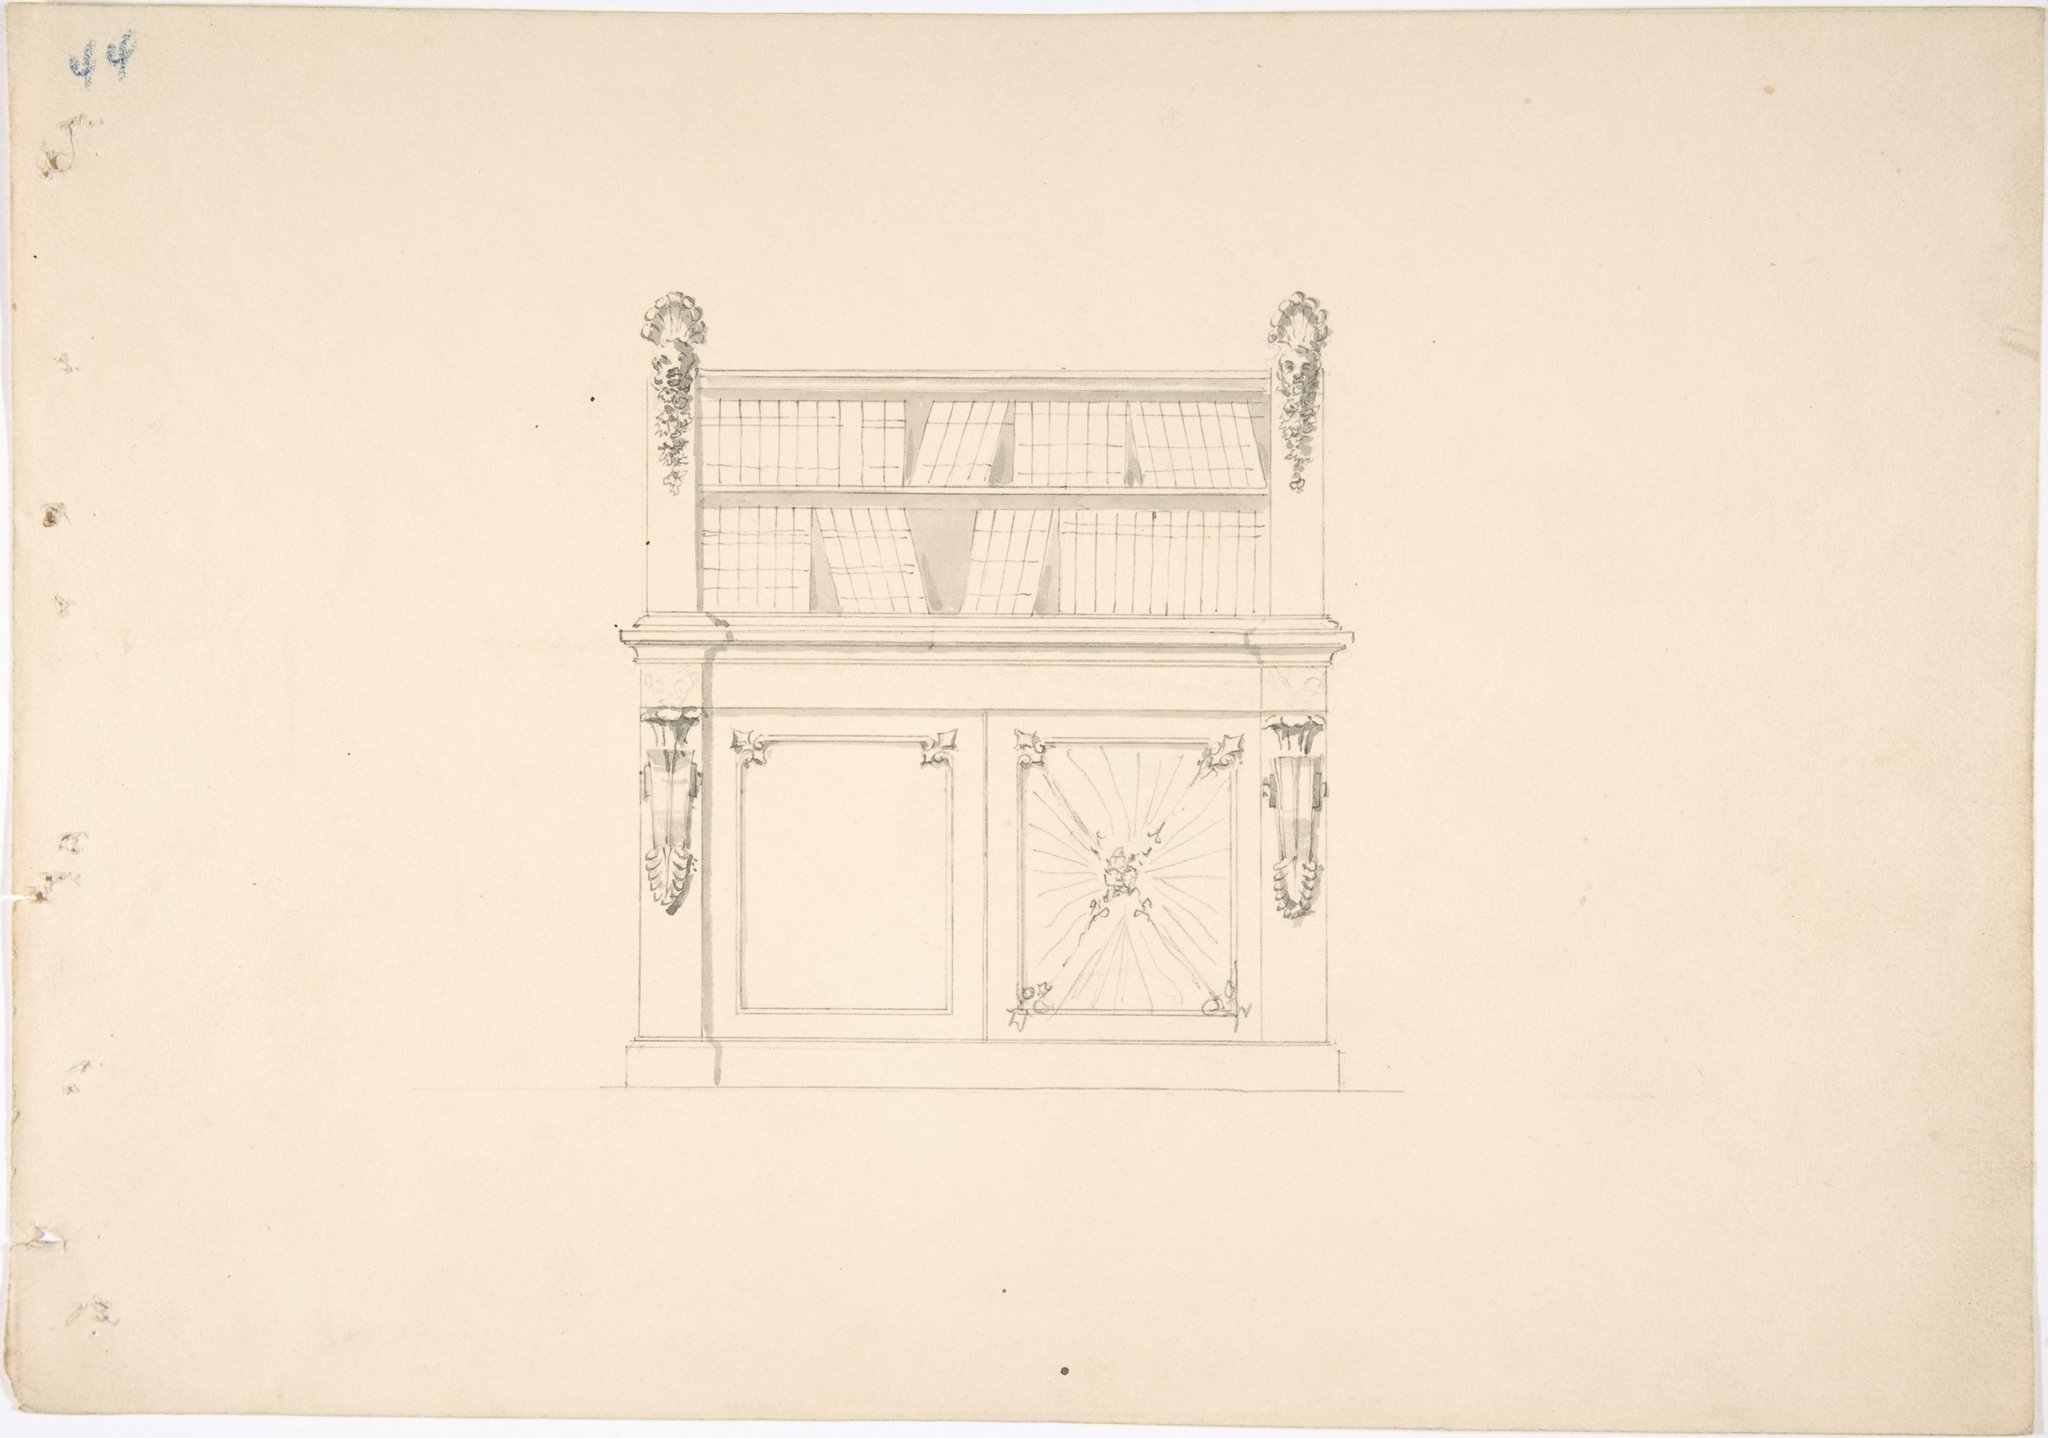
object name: drawing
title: Design for a Cabinet with Classical Ornament and Bookshelves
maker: anonymous, british, 19th century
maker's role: artist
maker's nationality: british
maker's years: 1800-1900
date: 1801-1833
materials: graphite, ink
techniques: brush, pen, wash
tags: cabinets